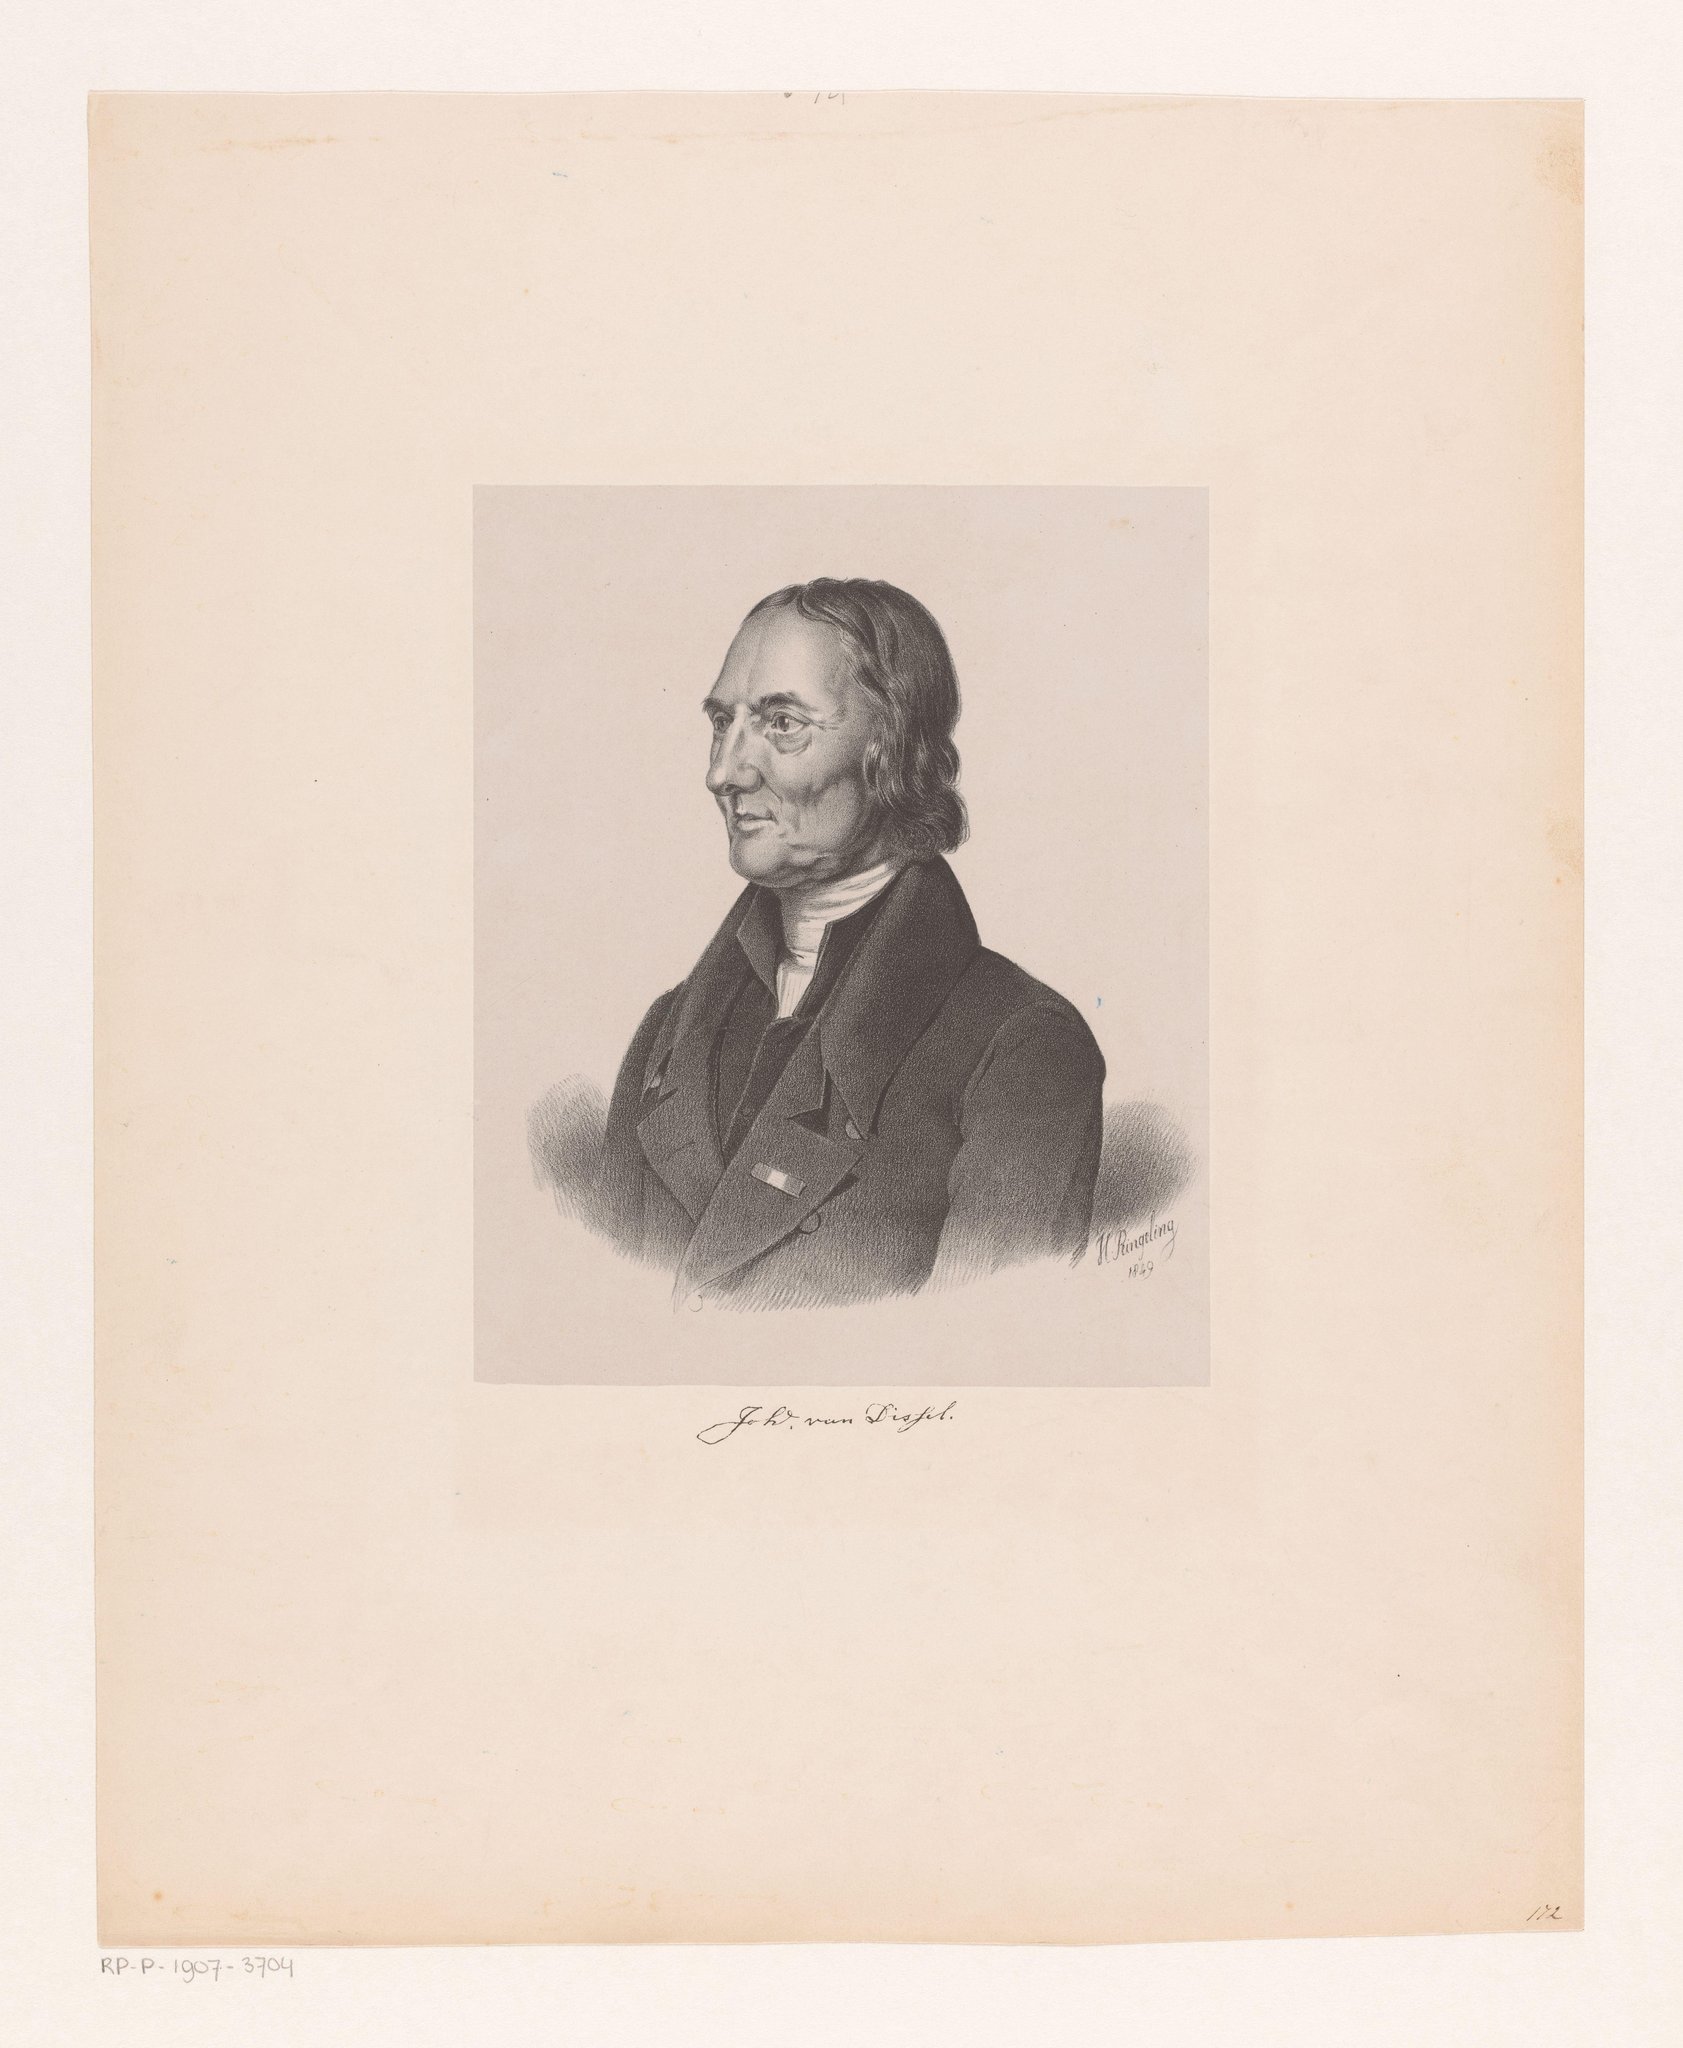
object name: print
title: Portret van Johan van Dissel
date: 1849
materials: paper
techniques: lithograph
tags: johan van dissel, historical persons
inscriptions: collector's mark: Lugt 2228